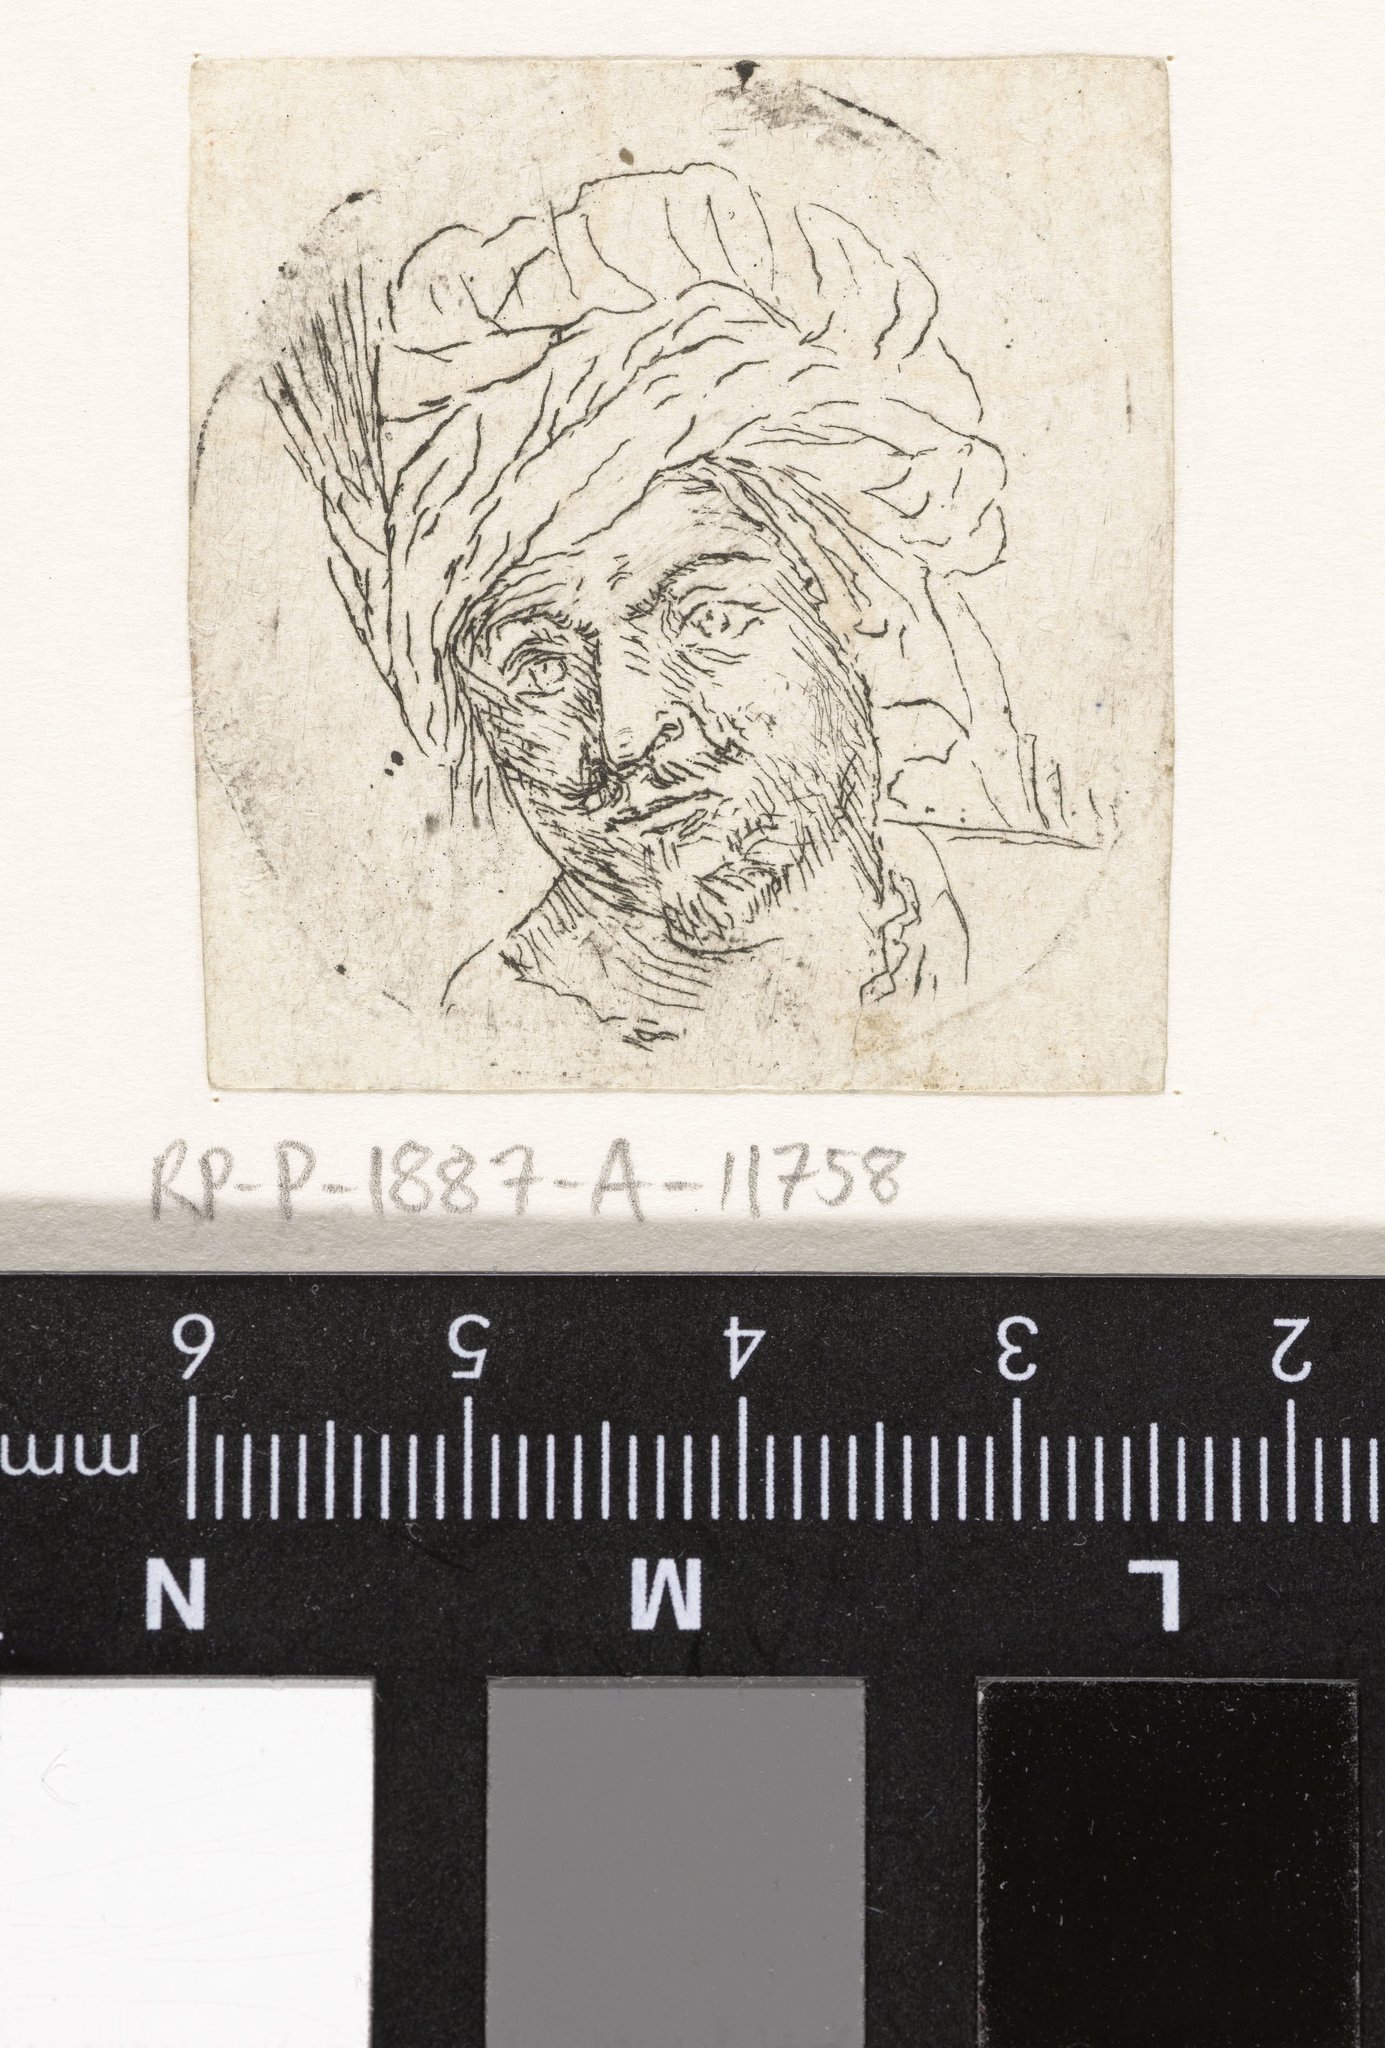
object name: print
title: Manshoofd met tulband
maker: marie lambertine coclers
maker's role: conservator, draughtsman, print maker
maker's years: 1761-1815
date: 1776-1815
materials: paper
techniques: etching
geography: amsterdam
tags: head-gear: turban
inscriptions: collector's mark: Lugt 2228